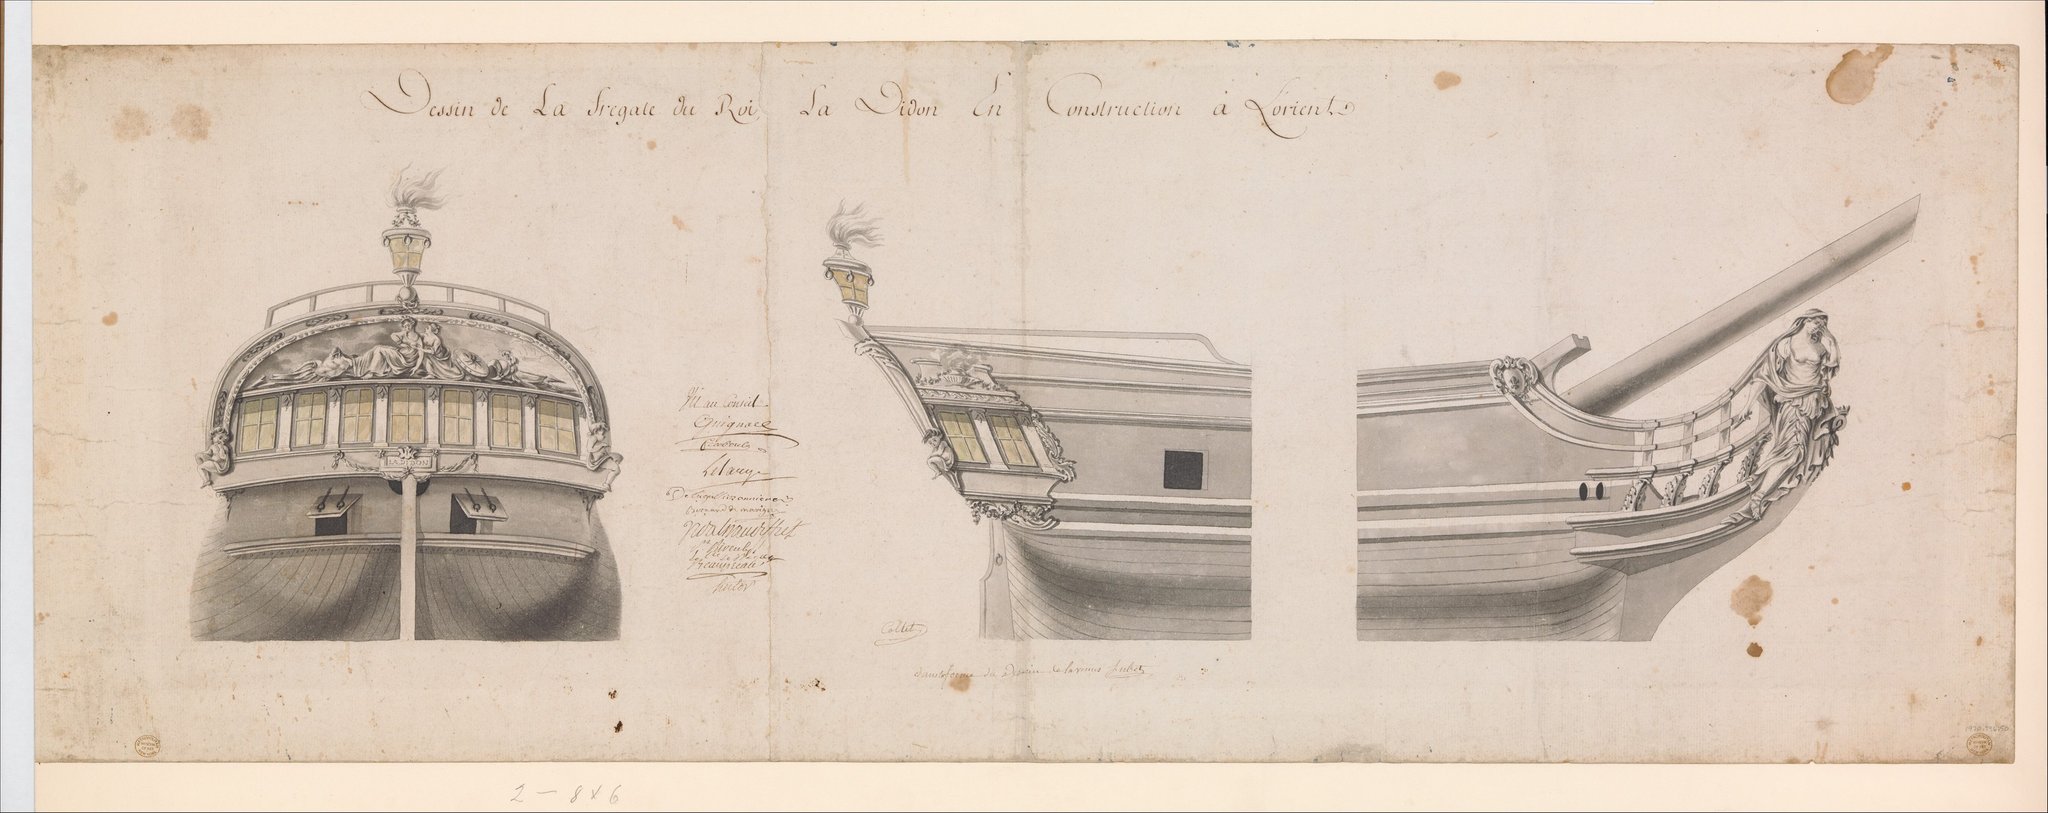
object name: drawing ornament architecture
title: Design for the Frigate "La Didion"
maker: anonymous, french, 18th century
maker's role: artist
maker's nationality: french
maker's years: 1700-1800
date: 1701-1800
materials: ink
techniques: brush, pen, wash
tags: ships